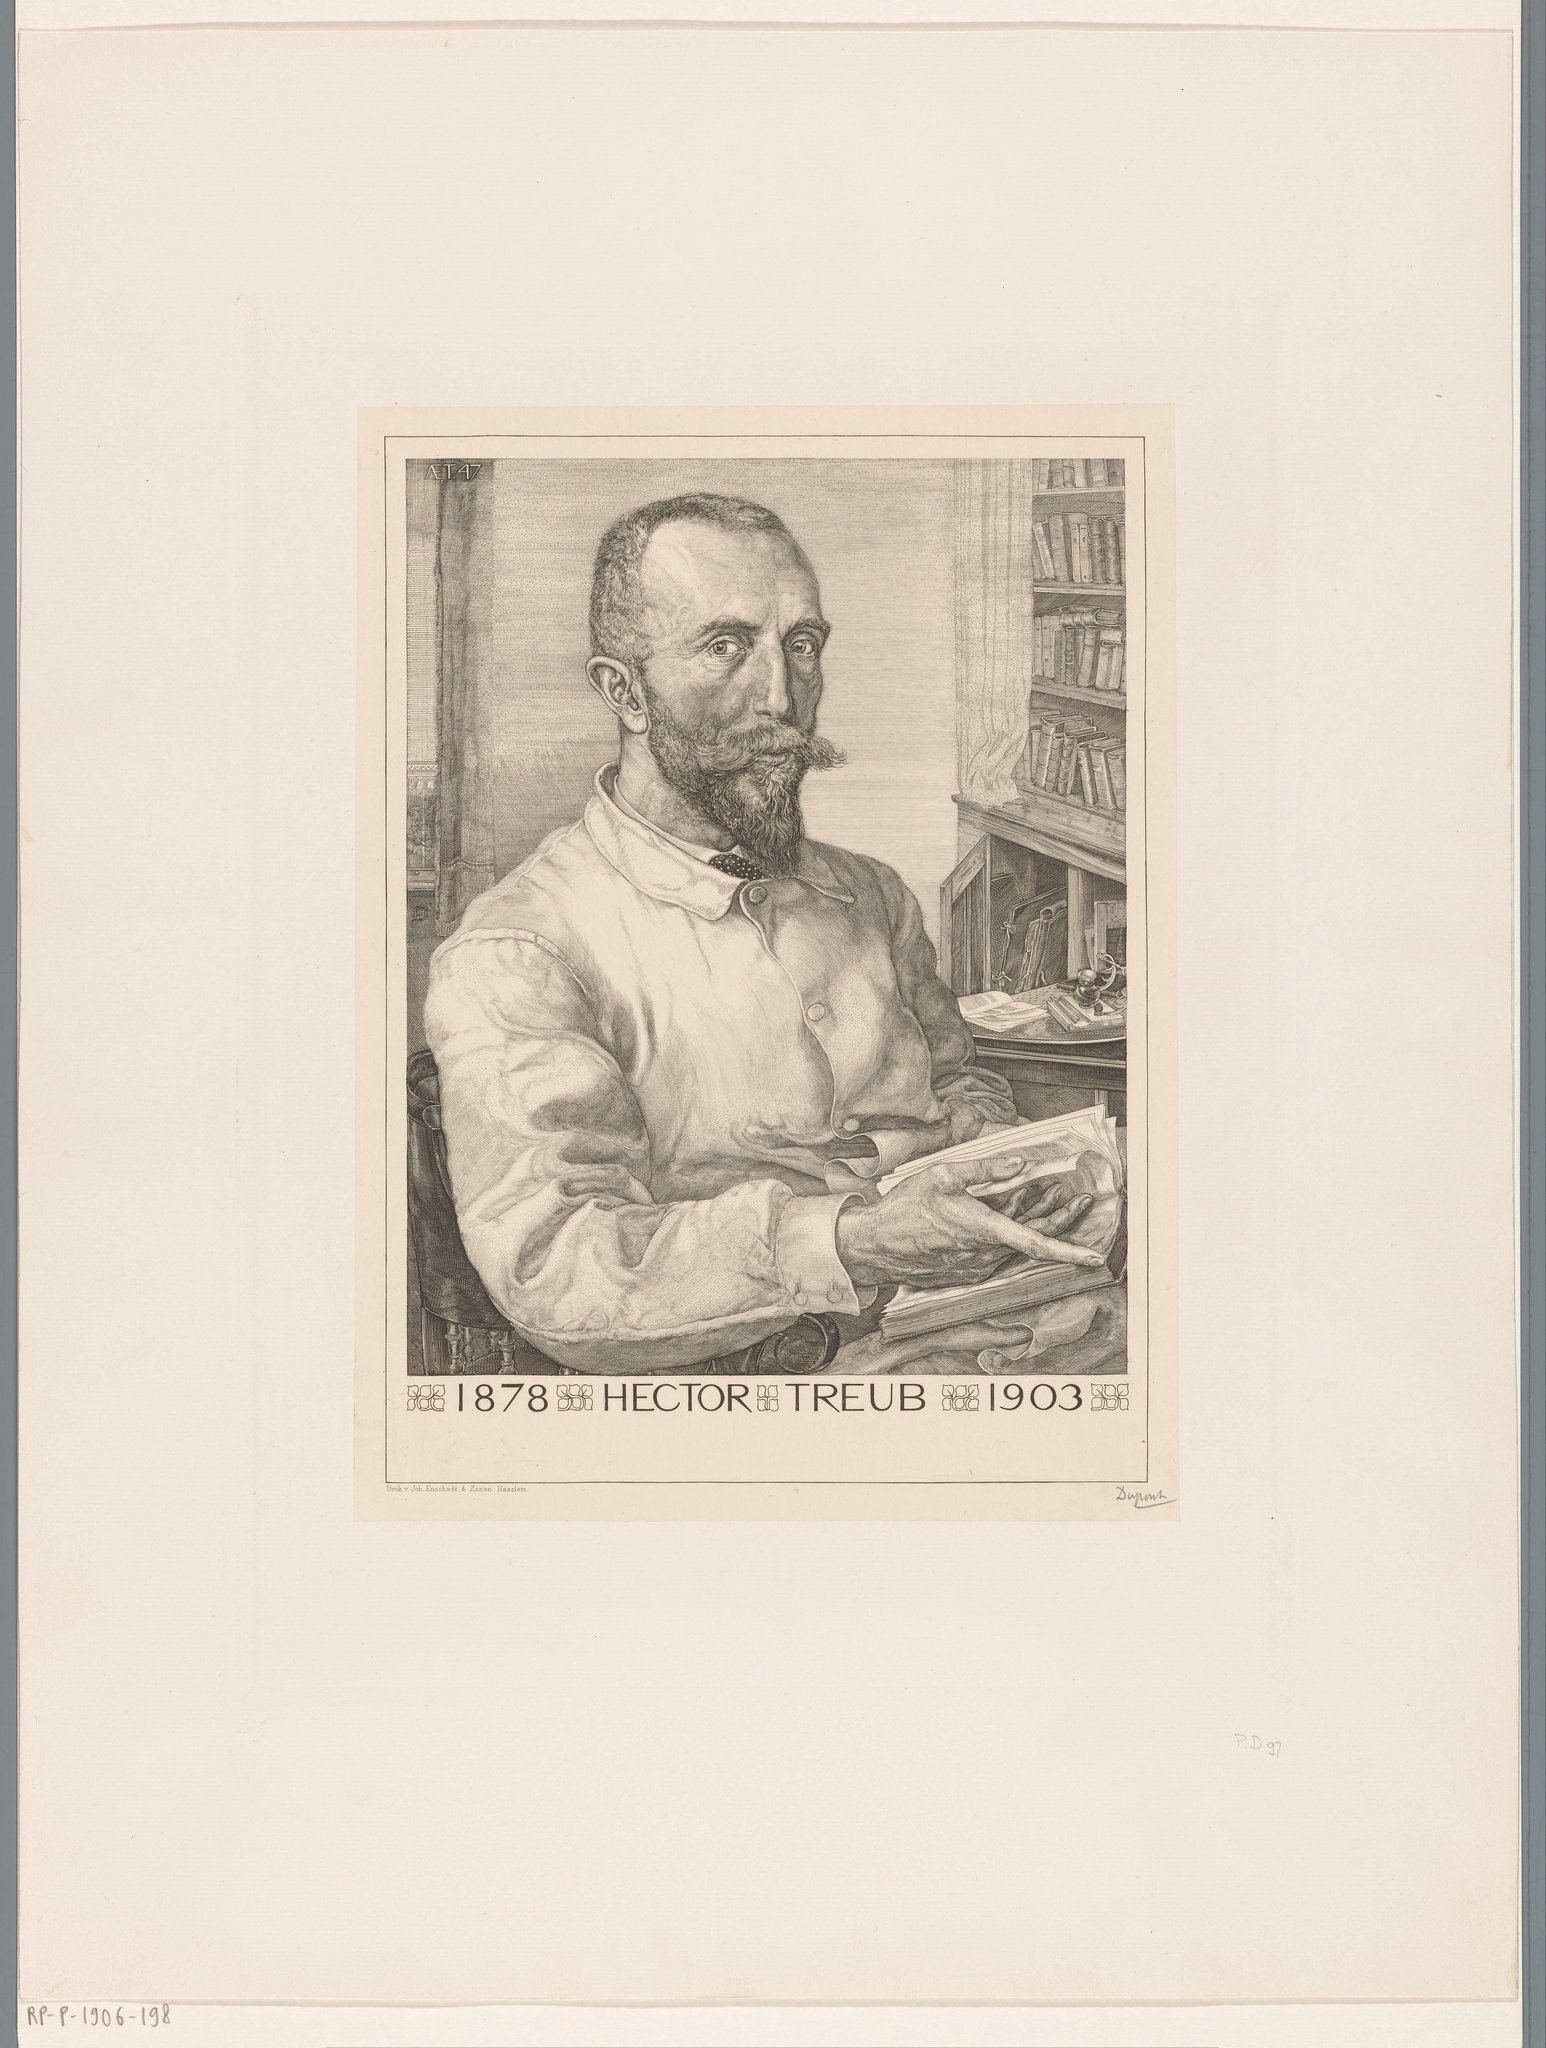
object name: print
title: Portret van Hector Treub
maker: pieter dupont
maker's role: draughtsman, print maker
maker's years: 1870-1911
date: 1903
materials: paper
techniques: engraving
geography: haarlem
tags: voorschoten, utrecht, physician, doctor, book, beard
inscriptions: collector's mark: Lugt 2228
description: Portret van de arts Hector Treub met baard en snor, zittend in zijn werkkamer. Op zijn schoot een opengeslagen boek, rechts een boekenkast. Linksboven de tekst 'AET. 47', de leeftijd van Treub op het moment van portretteren. Onderaan de jaartallen '1878', het jaar waarin Treub tot doctor in de geneeskunde promoveerde, en '1903', het jaar van zijn vijfentwintigjarig jubileum als arts.